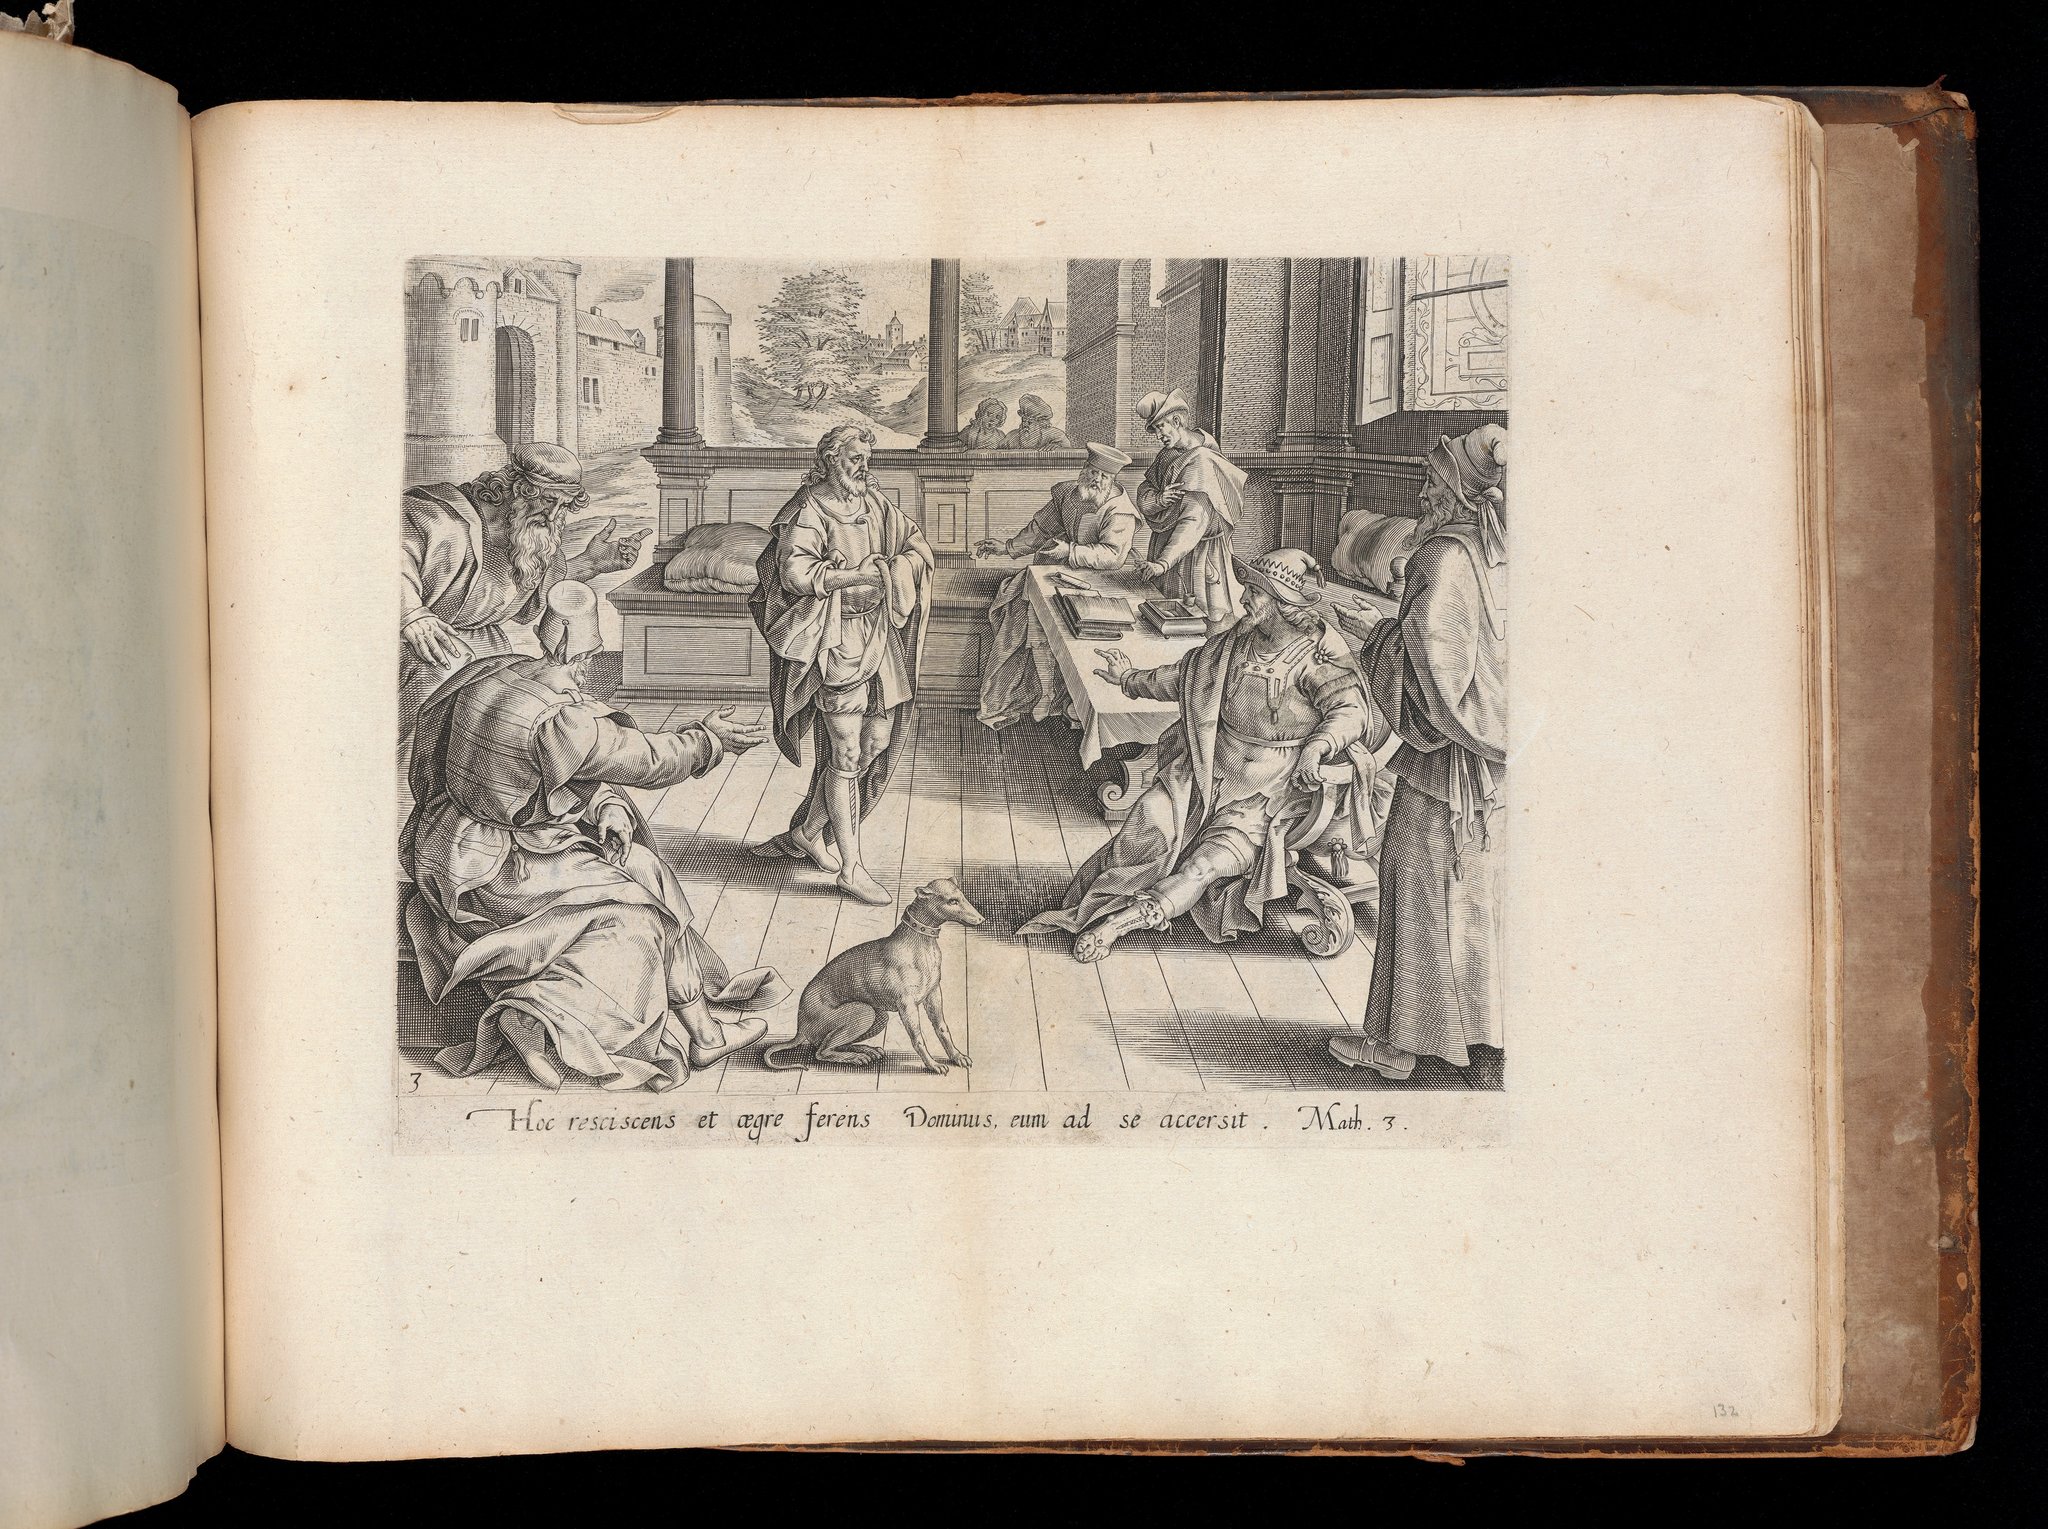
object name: book print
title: The King Summoning the Servant, from The Parable of the Unmerciful Servant, bound in "Thesaurus Sacrarum historiarum Veteris et Novi Testamenti"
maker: anonymous, netherlandish, 16th century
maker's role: engraver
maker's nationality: netherlandish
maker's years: 1500-1600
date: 1585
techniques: engraving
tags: men,dogs